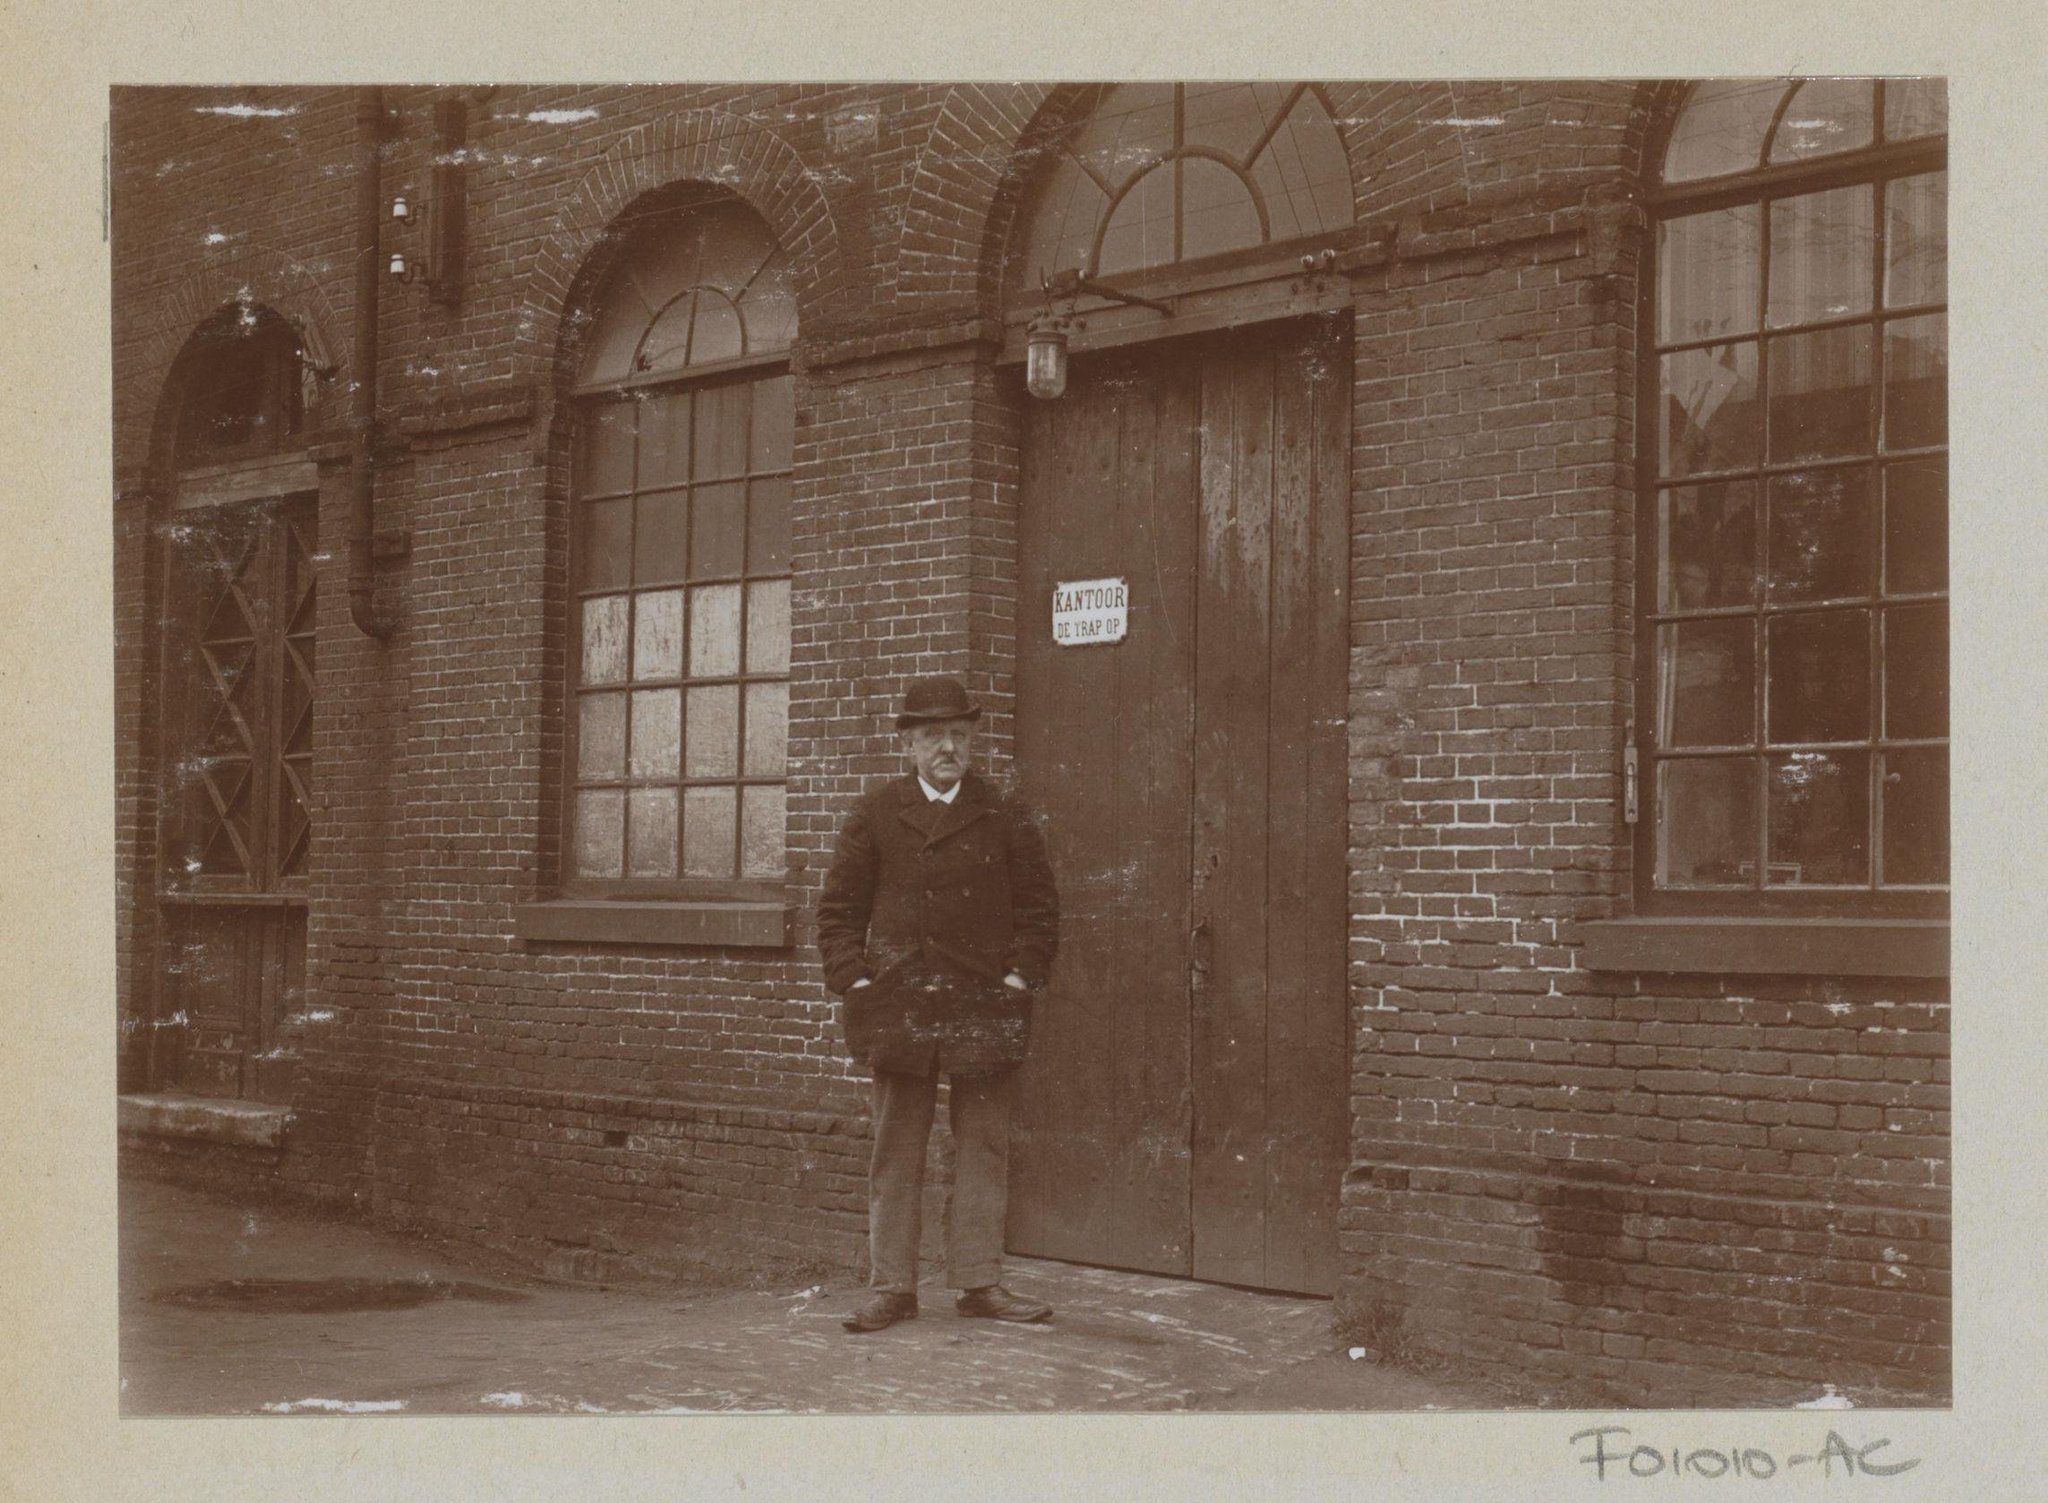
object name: photograph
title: Man staand voor een kantoordeur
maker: Anonymous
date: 1900-1910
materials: photographic support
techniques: collodion silver print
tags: factory-building, administration ~ trade and finance, head-gear: hat (+ men's clothes)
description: Onderdeel van Familiealbum met onder meer foto's van Wijnhandel Kraaij & Co. Bordeaux-Amsterdam.